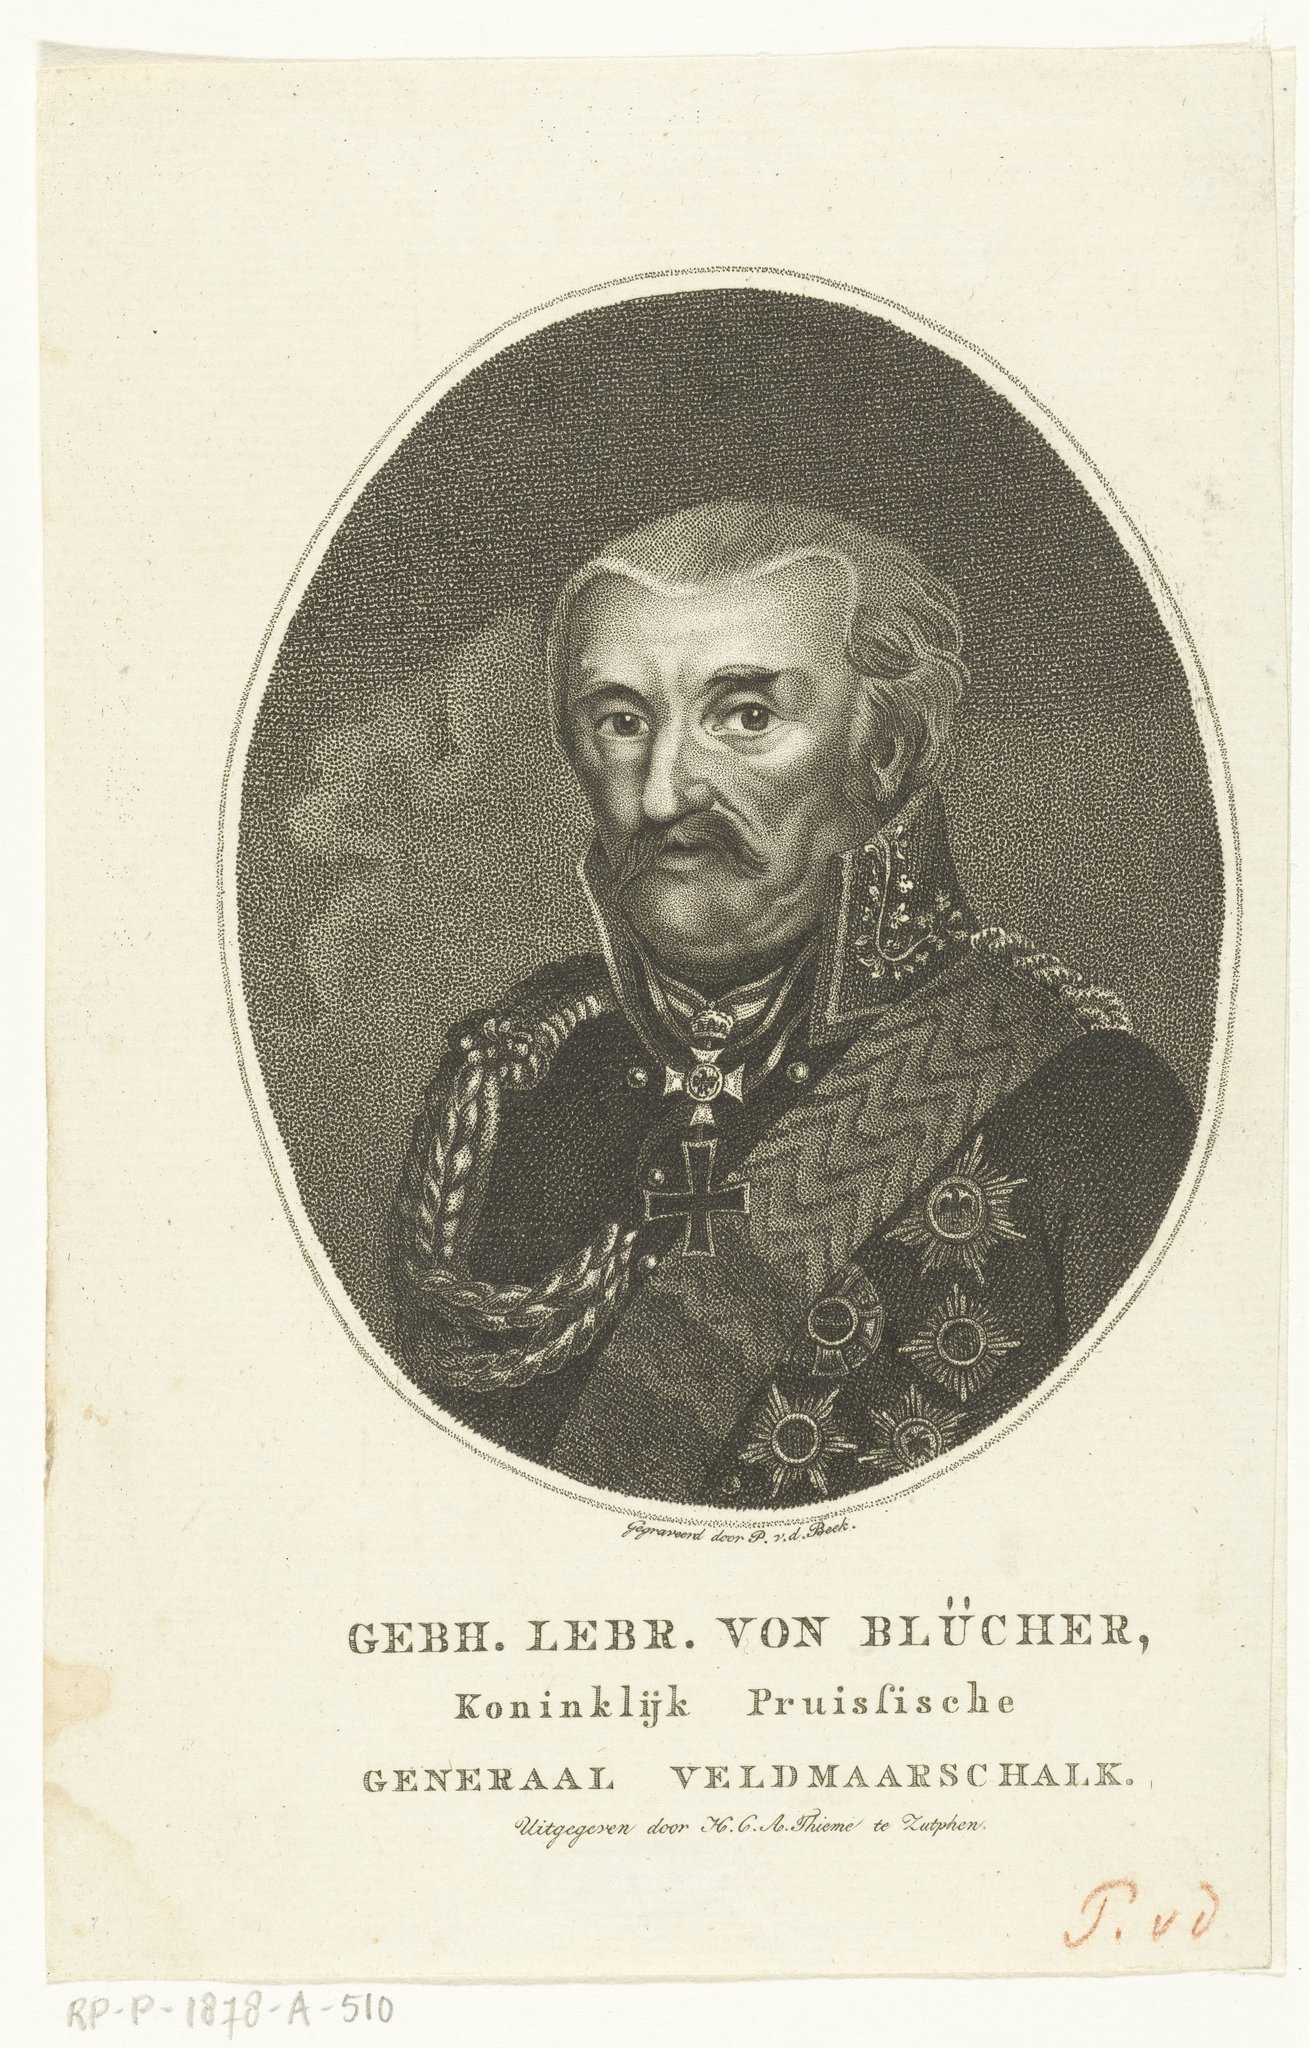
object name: print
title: Portret van Pruisische generaal Gebhard Leberecht von Blücher vorst van Wahlstatt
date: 1800-1821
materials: paper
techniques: etching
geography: zutphen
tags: rostock, generaal, gebhard leberecht von blücher von wahlstatt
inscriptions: collector's mark: Lugt 2228